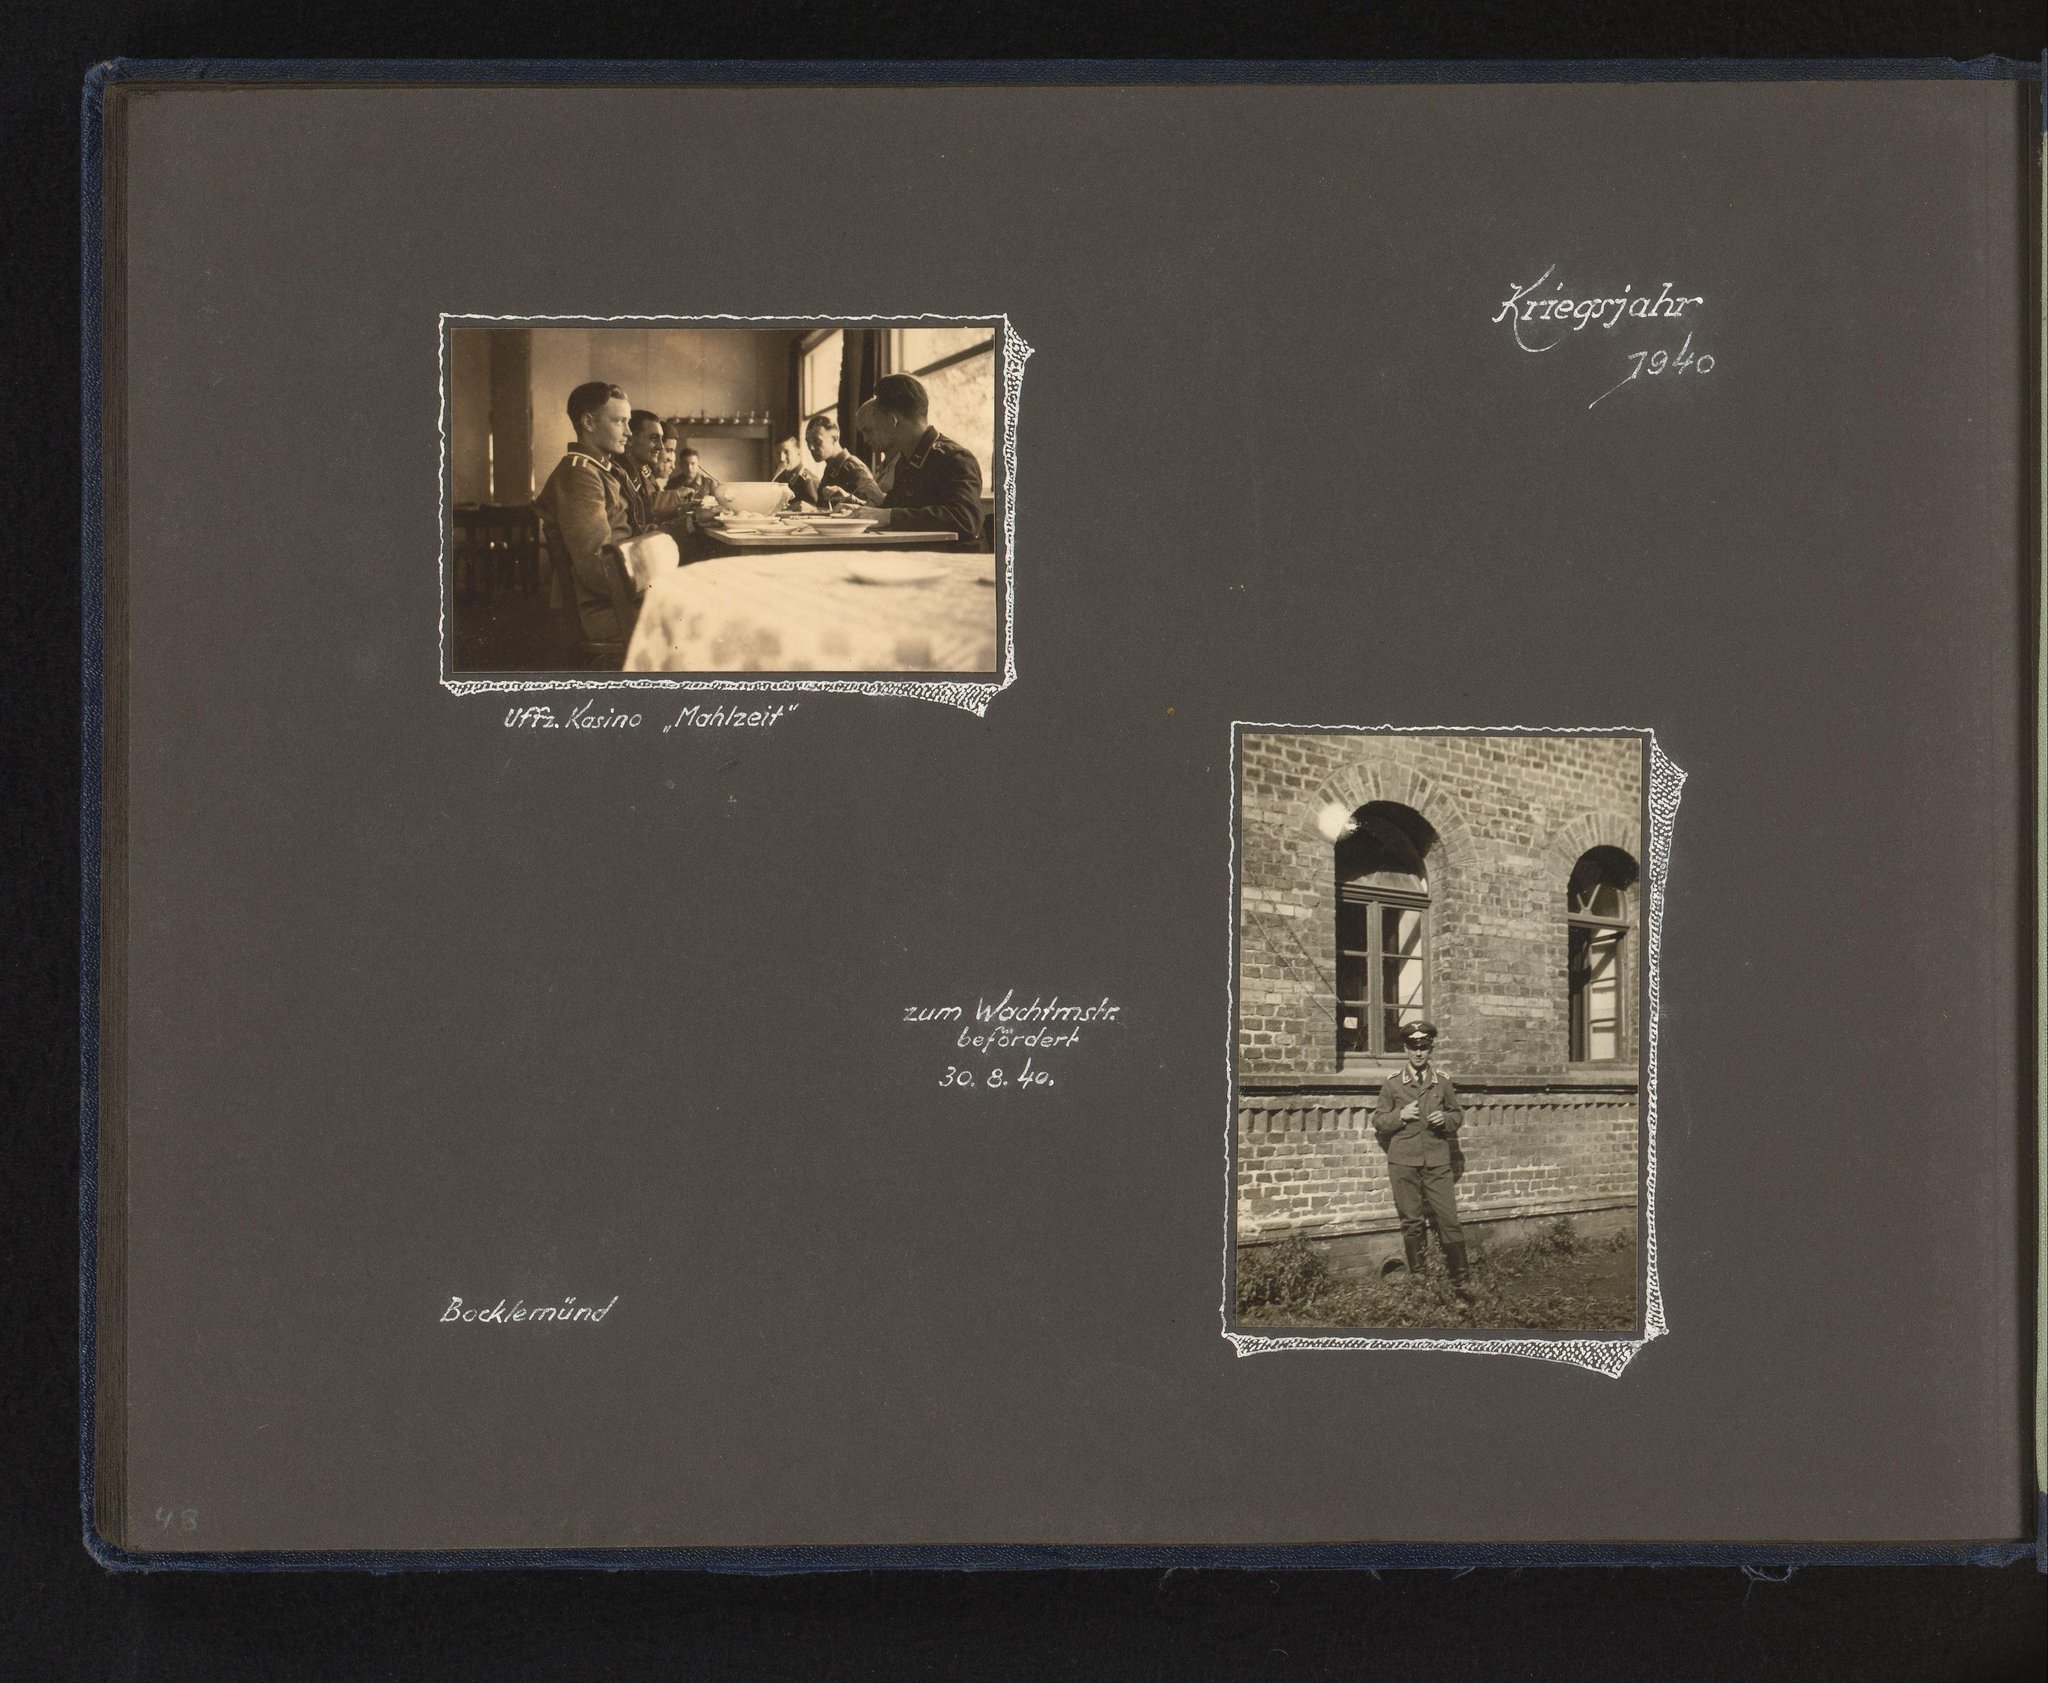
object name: album leaf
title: Kriegsjahr 1940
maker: Anonymous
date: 1908-1940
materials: paper, photographic support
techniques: gelatin silver print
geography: germany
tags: the company, the unit, the troop ~ military service, mess ~ the soldier off duty, germany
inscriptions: date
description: Albumblad met twee foto's in Fort Bocklemünd (Keulen) in 1940. Boven een maaltijd van officieren, onder de samensteller alleen op de foto ter gelegenheid van zijn bevordering op 30 augustus 1940 tot wachtmeester (hier eindigt het fotoalbum). Onderdeel van een Duits militair album Tweede Wereldoorlog 1939-1940.